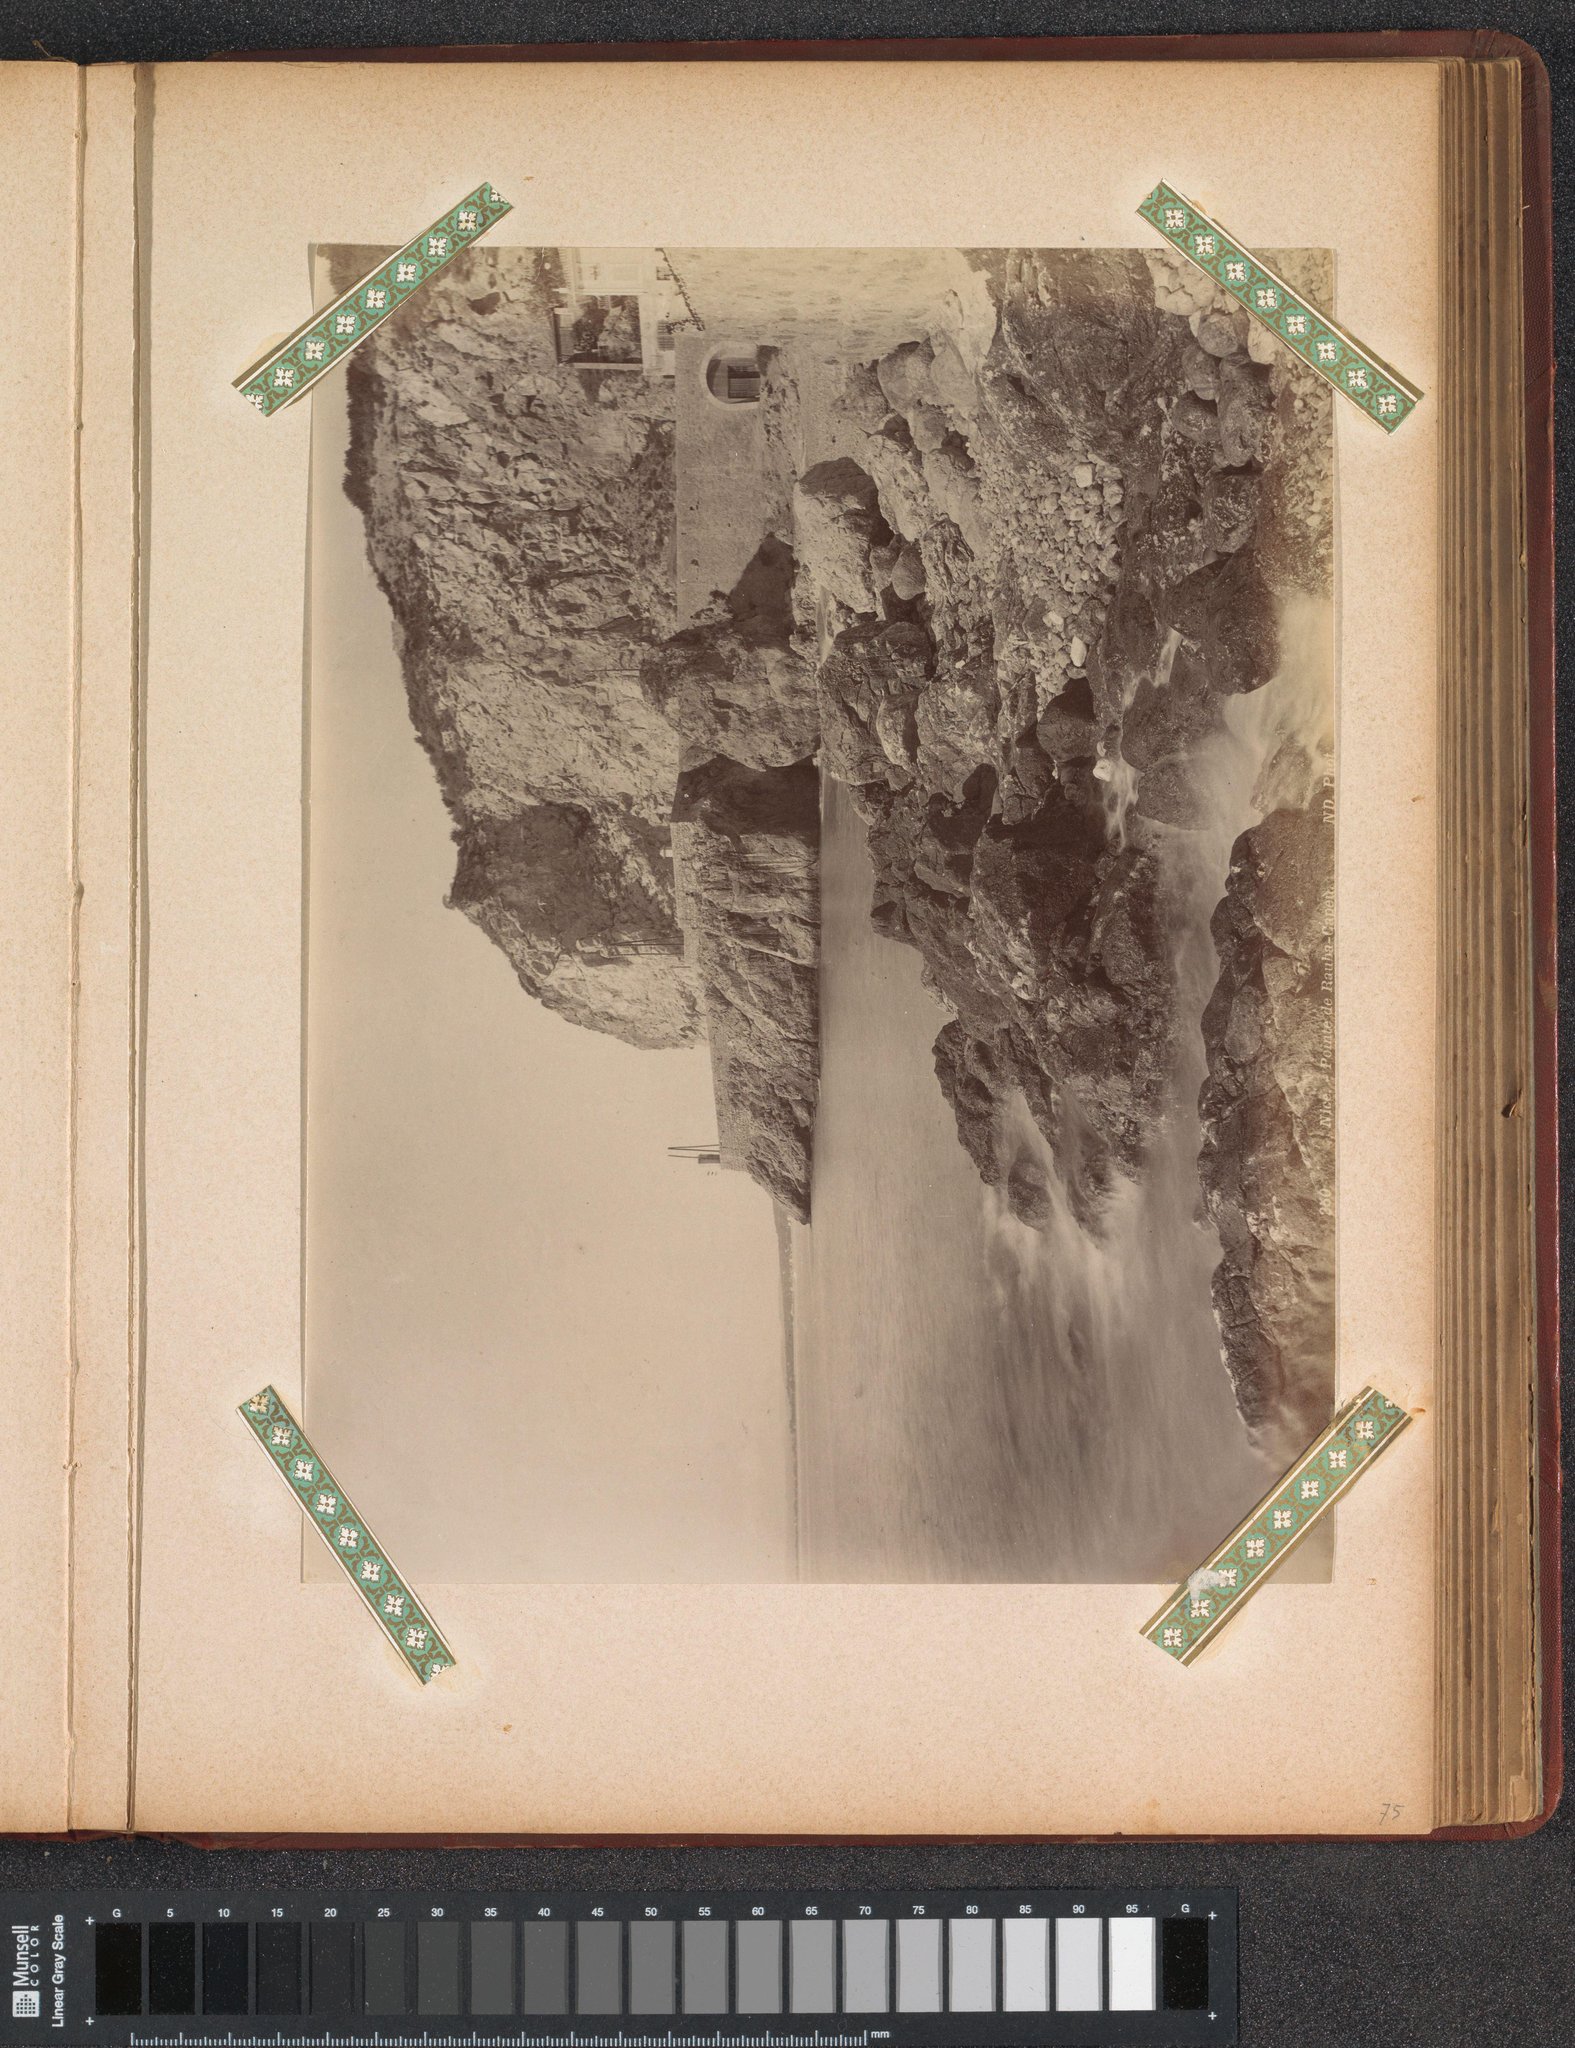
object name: album leaf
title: Nice. - Pointe de Rauba-Capeù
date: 1870-1900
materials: paper, photographic support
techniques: albumen print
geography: nice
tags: rocks (+ landscape with figures, staffage), coast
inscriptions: negative number: ‘350’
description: Onderdeel van Reisalbum met foto's van bezienswaardigheden in Italië en Zuid-Frankrijk.